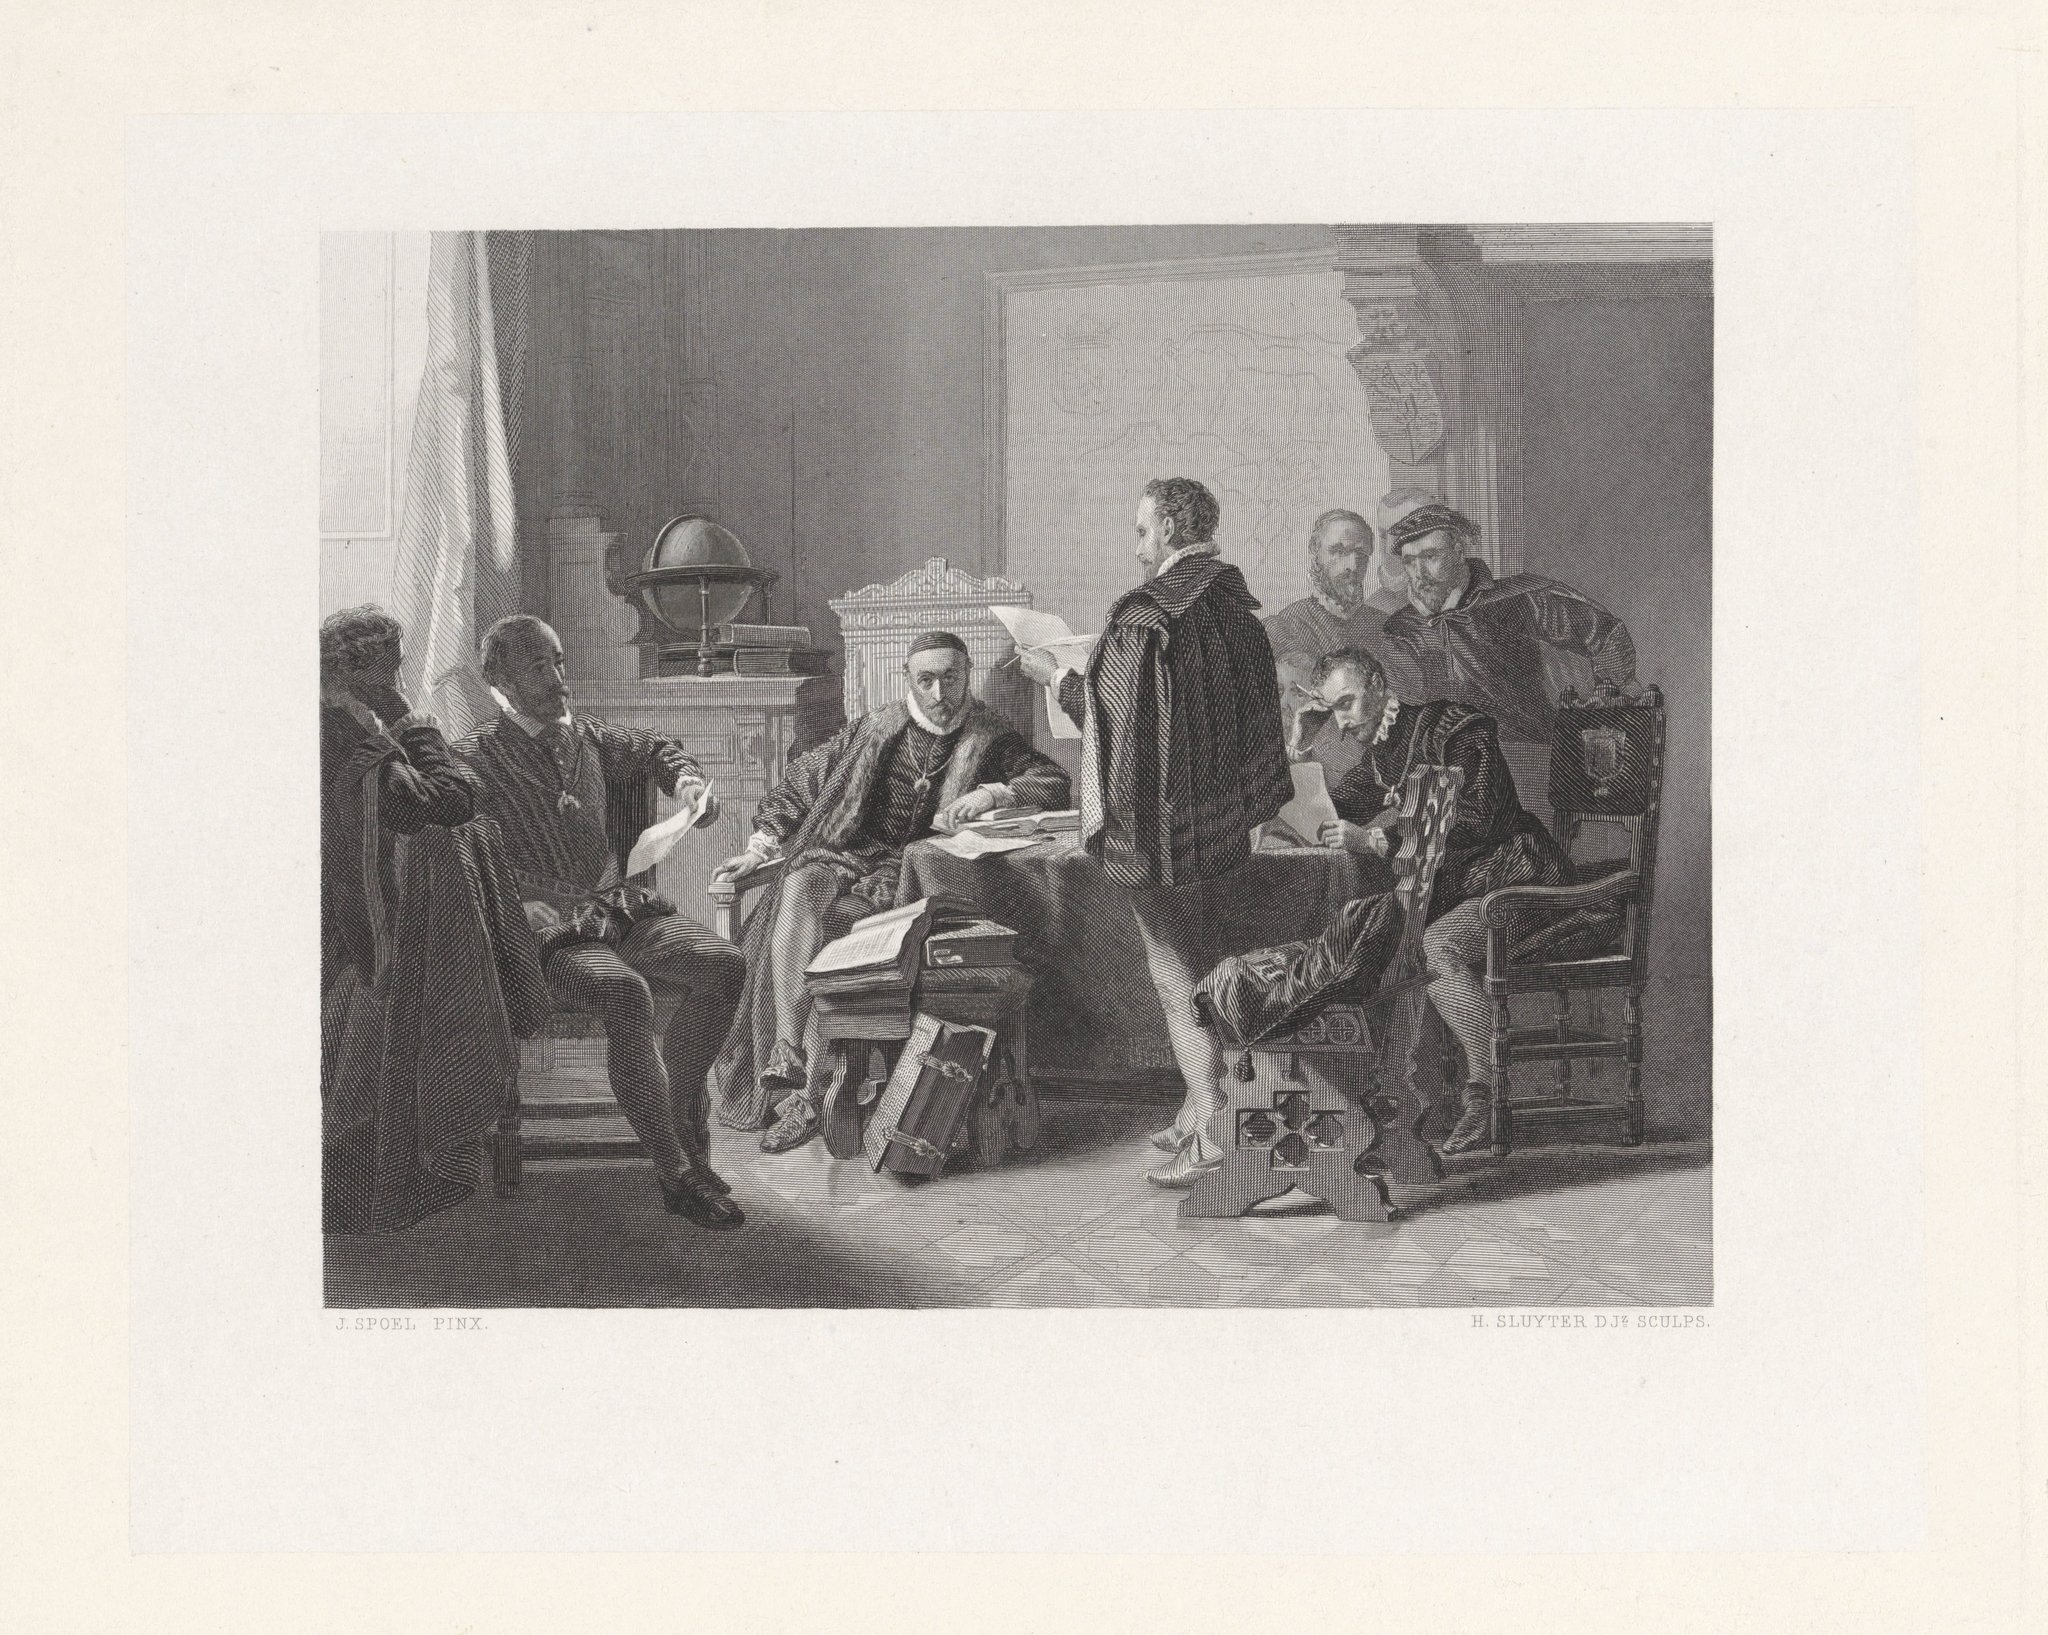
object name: book illustration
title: Filips van Marnix, heer van Sint-Aldegonde, leest zijn Wilhelmuslied voor aan Willem I (prins van Oranje)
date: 1865-1870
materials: paper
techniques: etching, engraving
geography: amsterdam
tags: delft, william i (prince of orange), brussels, leiden, filips van marnix van sint-aldegonde, maps, atlases, book, globe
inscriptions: collector's mark: Lugt 2228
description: Willem de Zwijger zit in een armstoel en luistert naar Filips van Marnix, die een tekst voorleest vanaf een vel papier. Hij houdt een schrijfveer in de hand. Zes andere heren staan of zitten om hen heen en kijken aandachtig toe. Aan Willems voeten staat een krukje, waarop en waarnaast lijvige folianten liggen. Aan de muur hangt een landkaart. Op een kastje staat een globe.